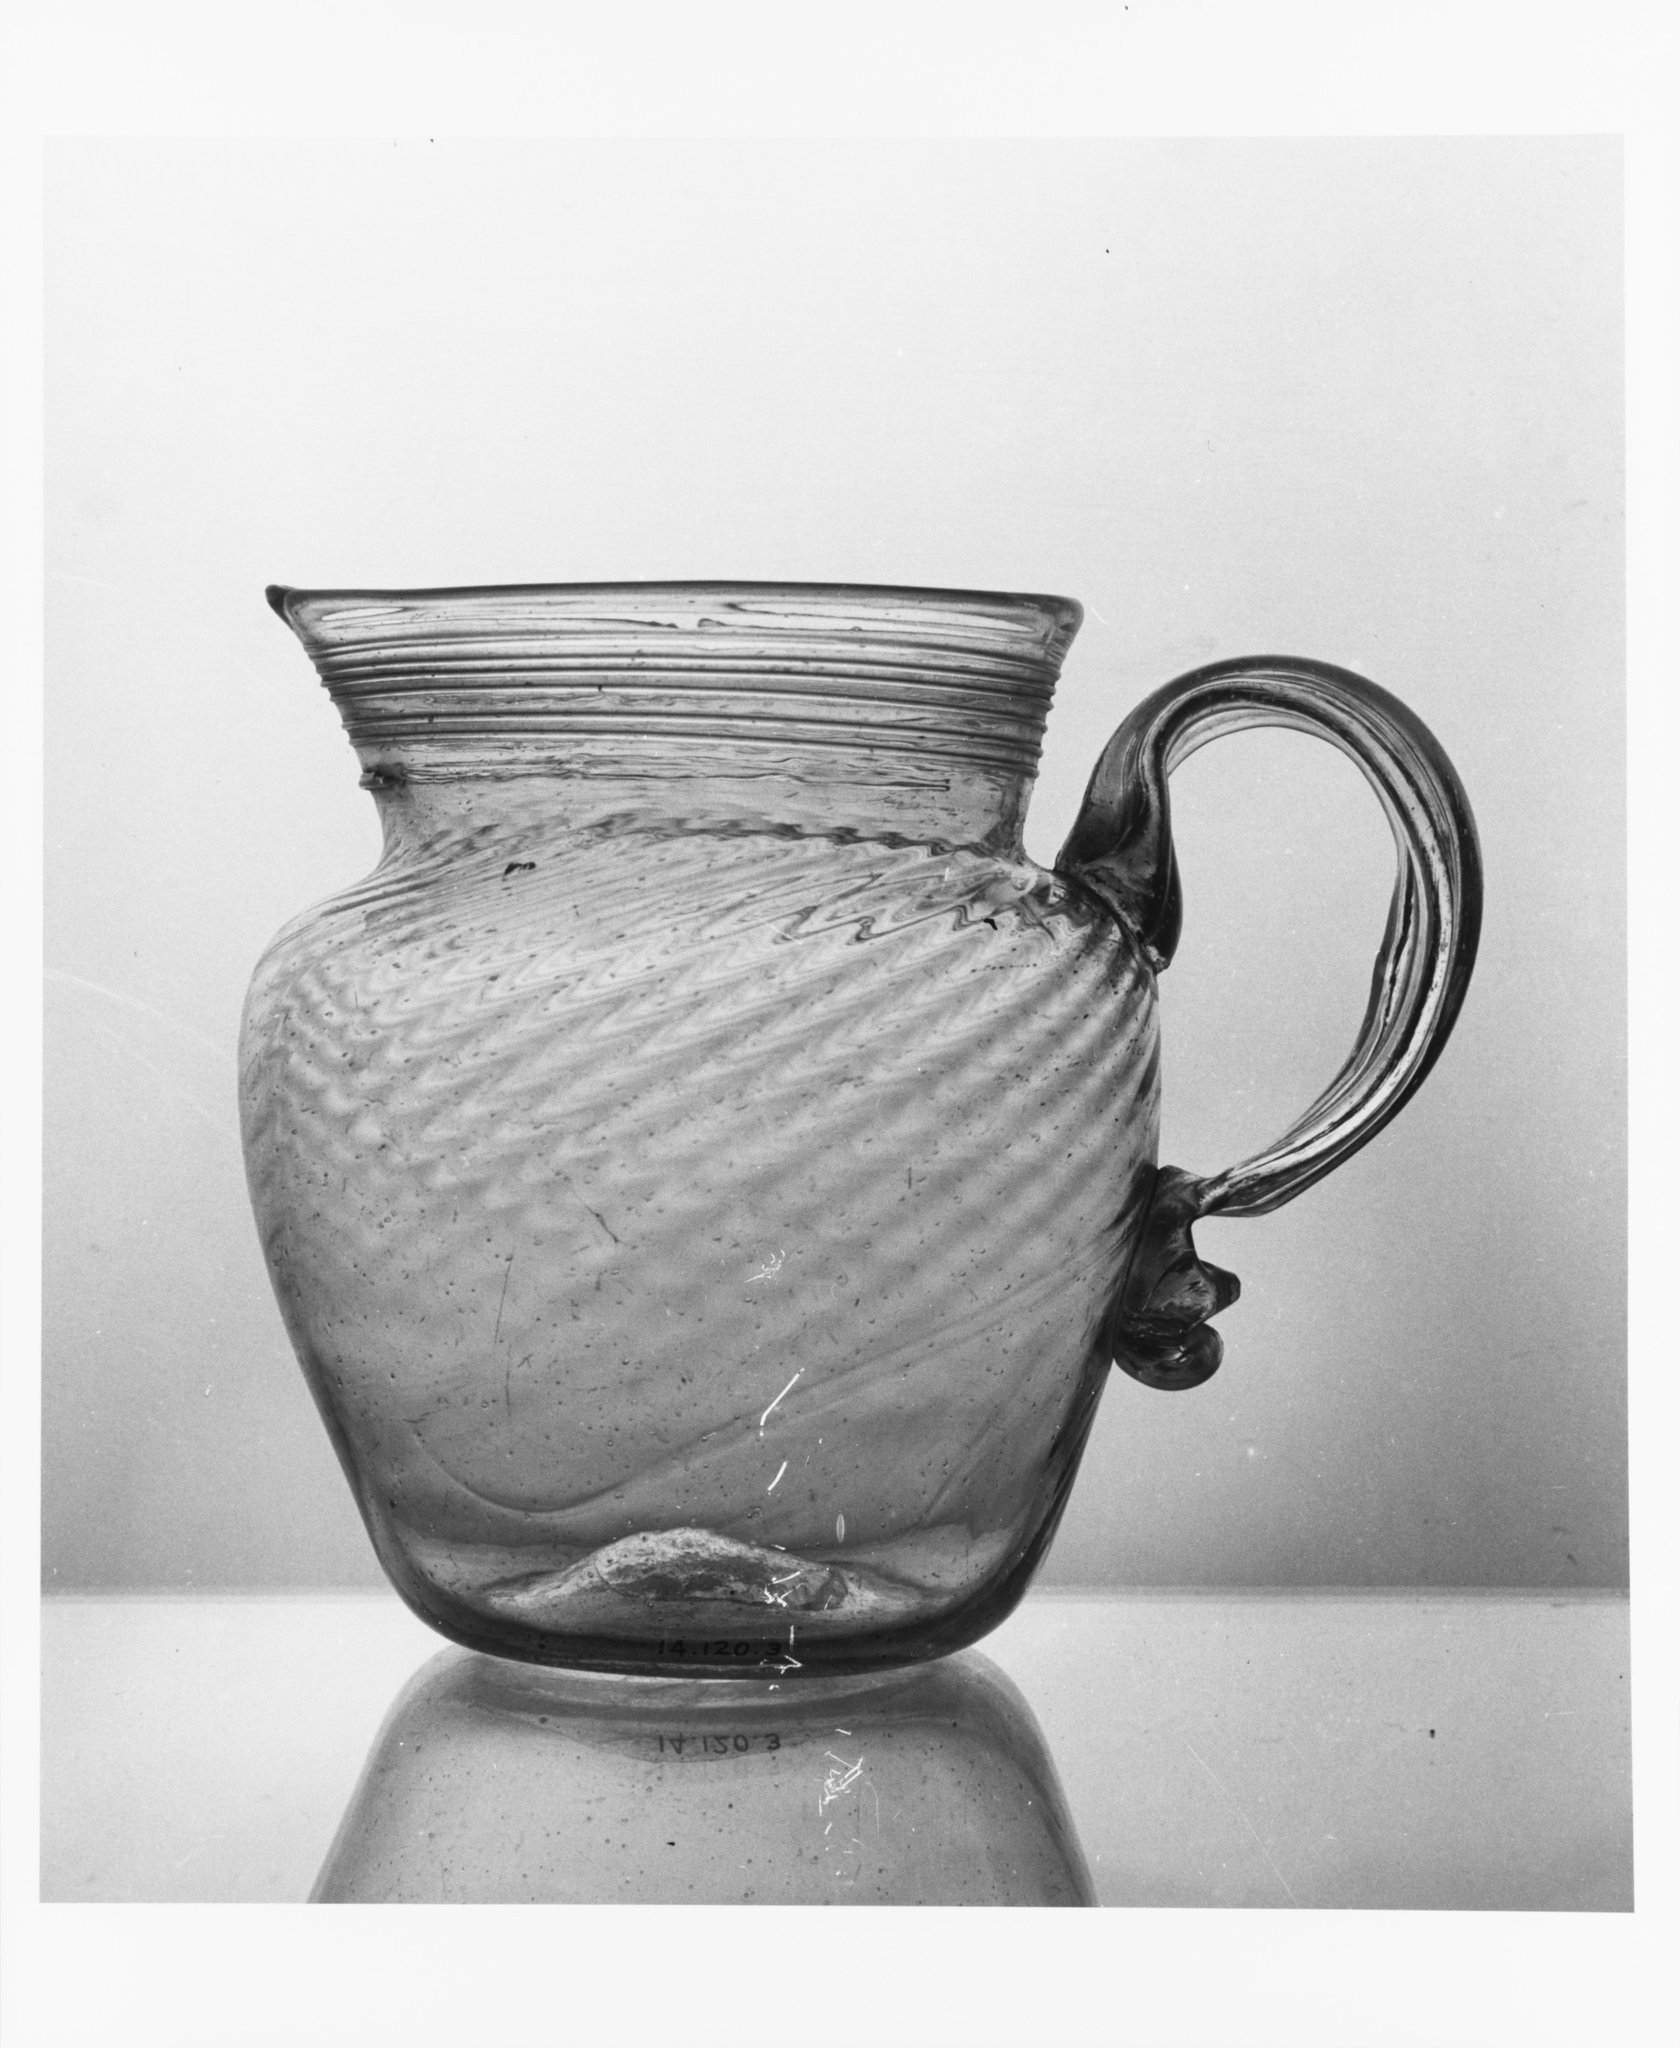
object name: pitcher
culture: american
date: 1800-1830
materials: gemstone, glass, lead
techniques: glassblowing, molding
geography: united states